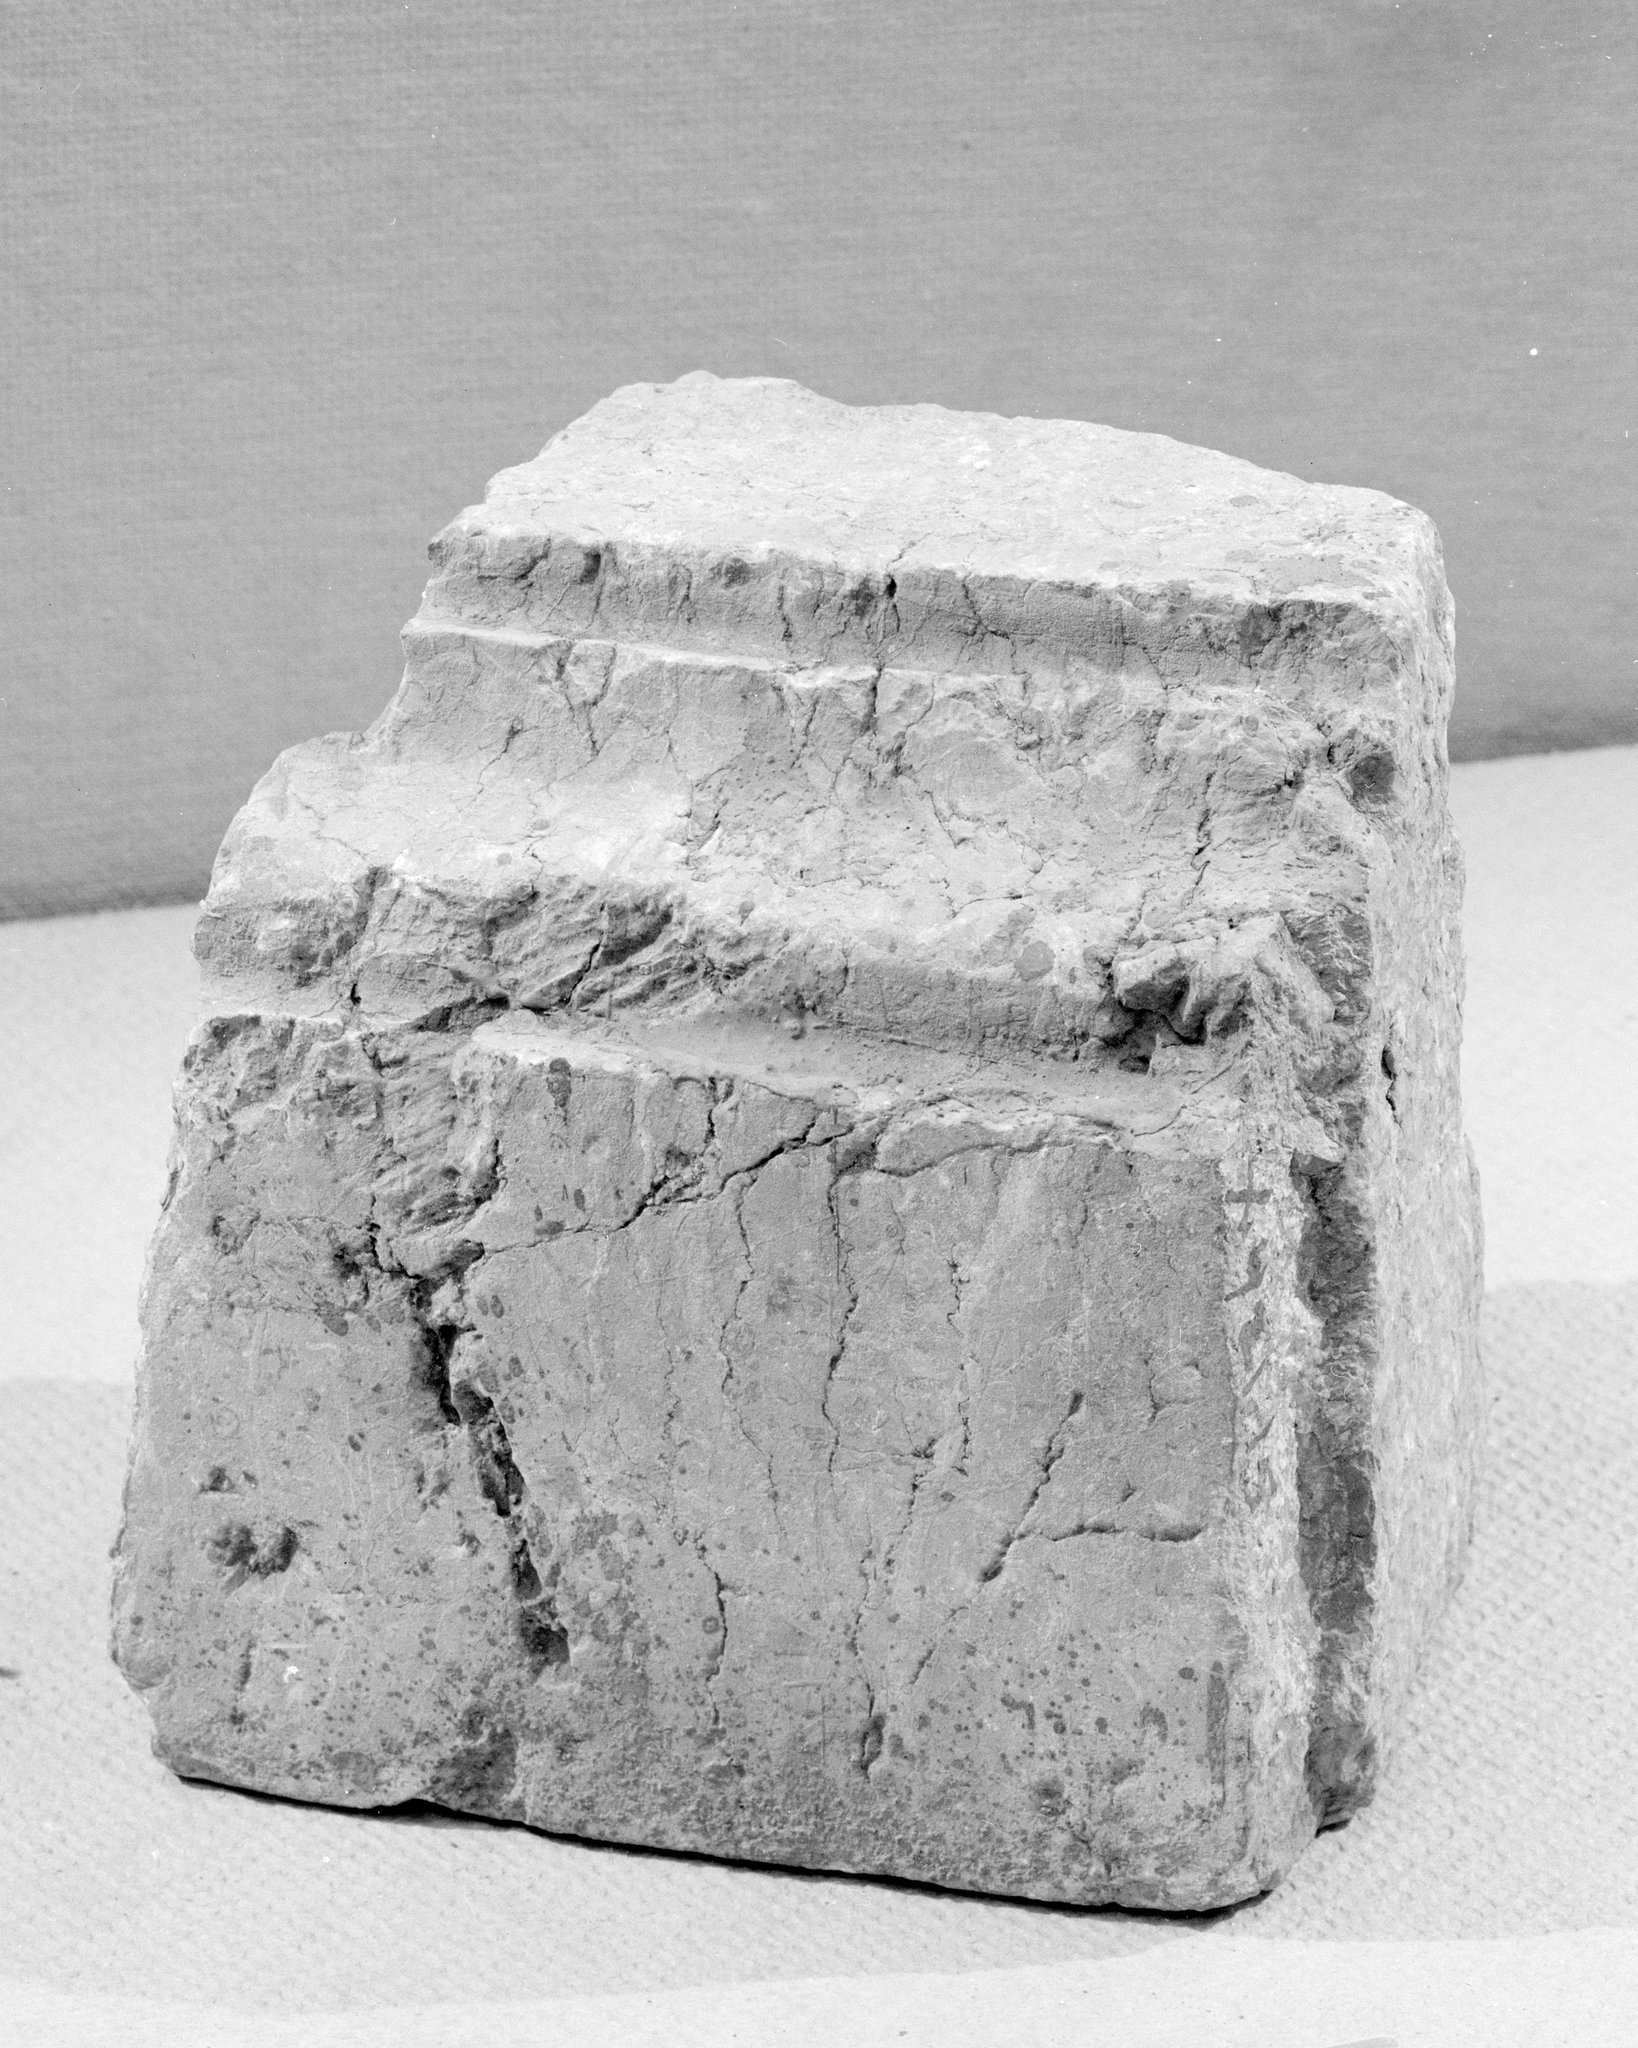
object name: block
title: Parapet Block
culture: french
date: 1130-1140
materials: stone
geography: france